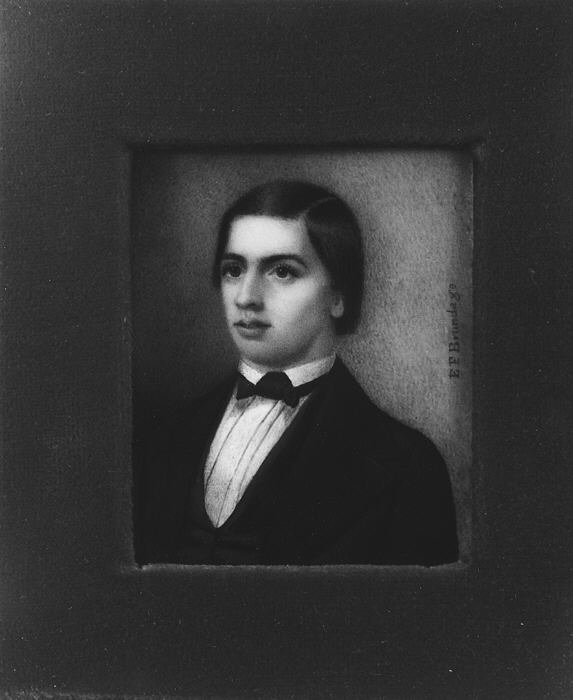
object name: painting, miniature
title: Portrait of a Gentleman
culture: american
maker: ebenezer f. brundage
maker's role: artist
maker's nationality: american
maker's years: 1805-1905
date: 1845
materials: ivory, watercolor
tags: men,portraits